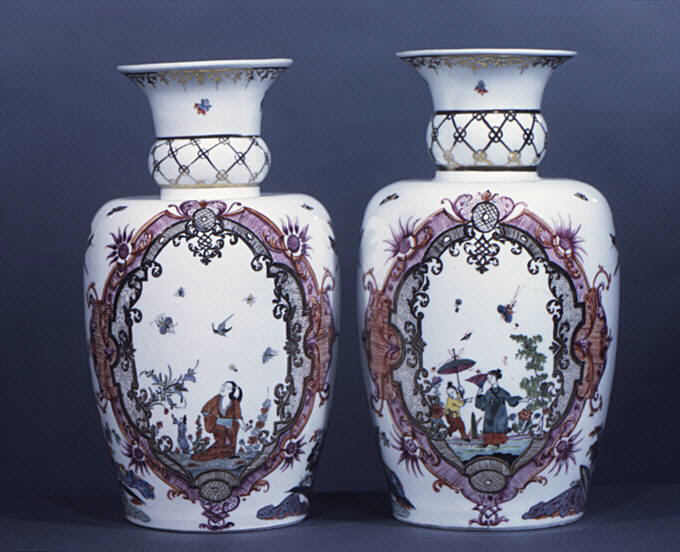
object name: vase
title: Vase (part of a set)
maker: meissen manufactory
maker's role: manufactory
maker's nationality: german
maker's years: 1710-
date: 1740-1750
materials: hard paste porcelain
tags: birds,chinoiserie,women,insects